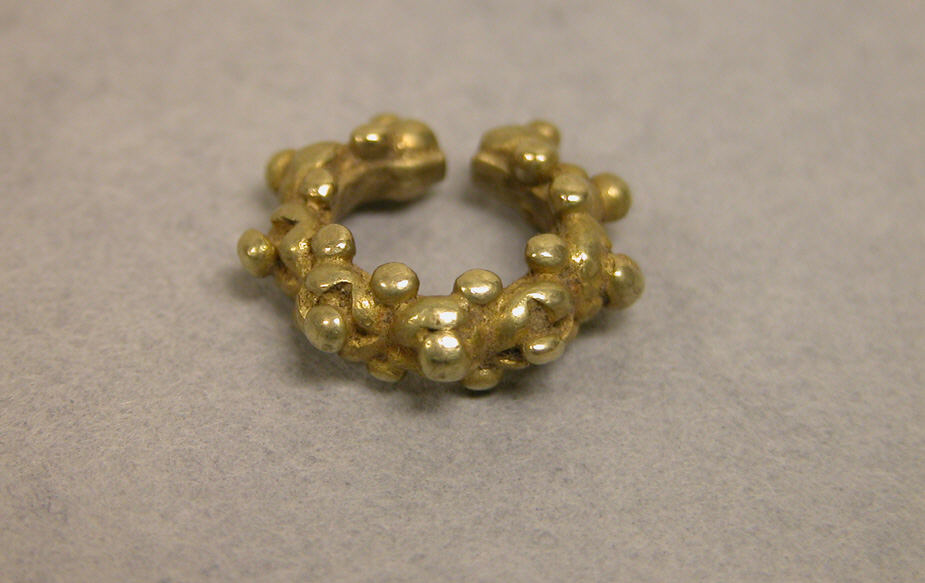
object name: earring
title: Earring with Repoussé Nodules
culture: indonesian, central java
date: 701-1200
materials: gold